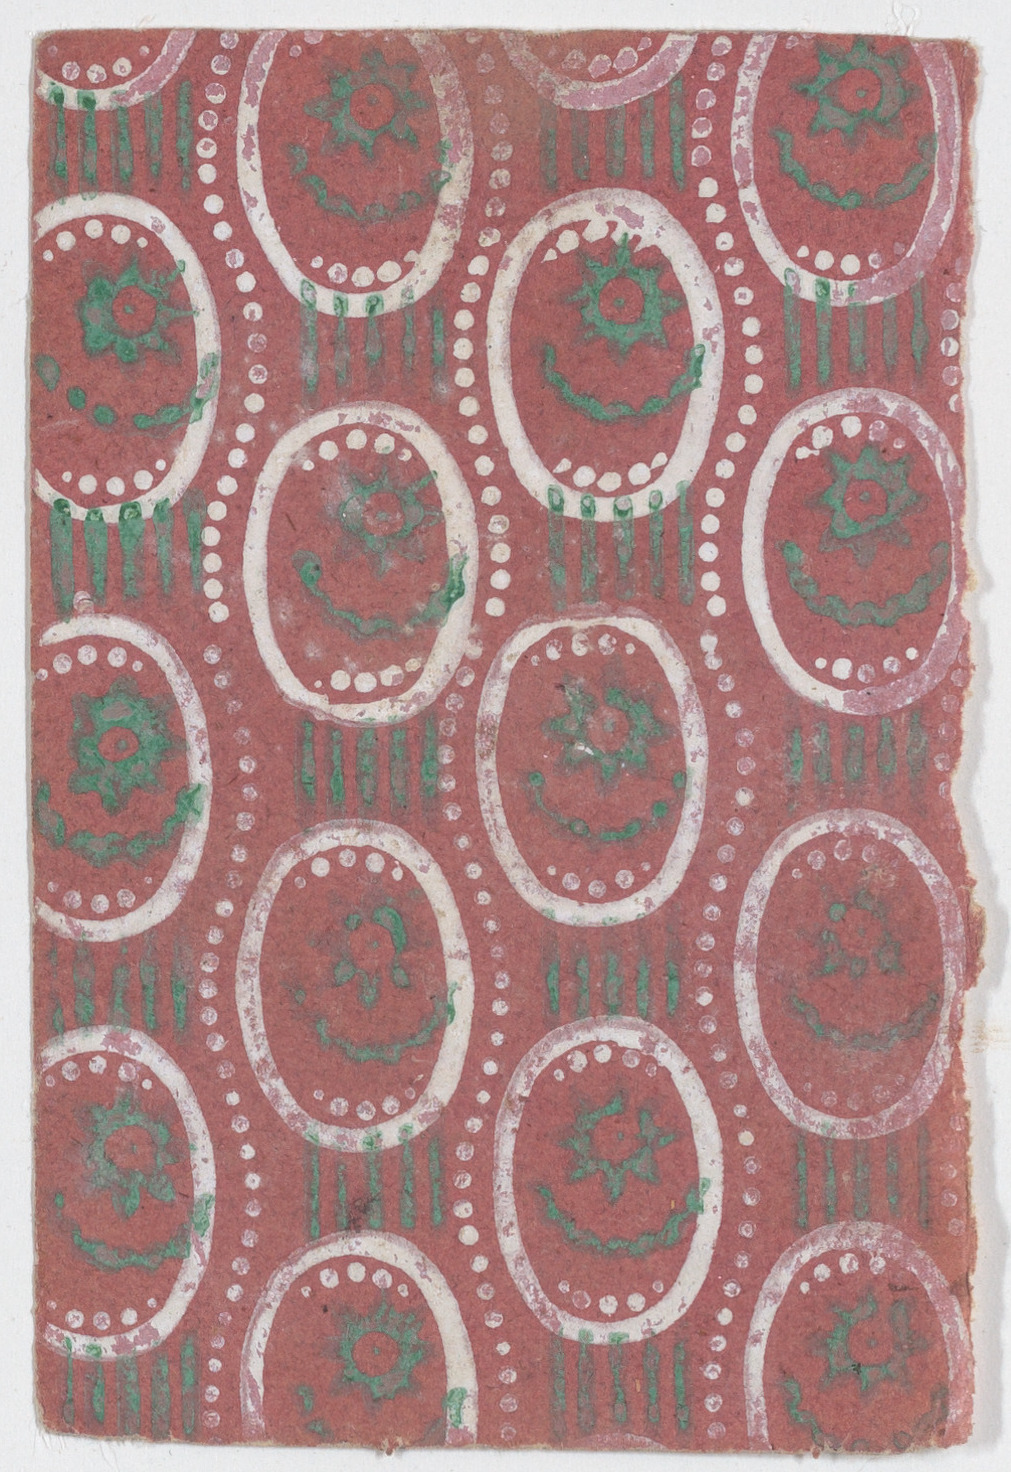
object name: print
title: Sheet with oval and dot pattern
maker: Anonymous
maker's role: artist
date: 1801-1900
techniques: relief print